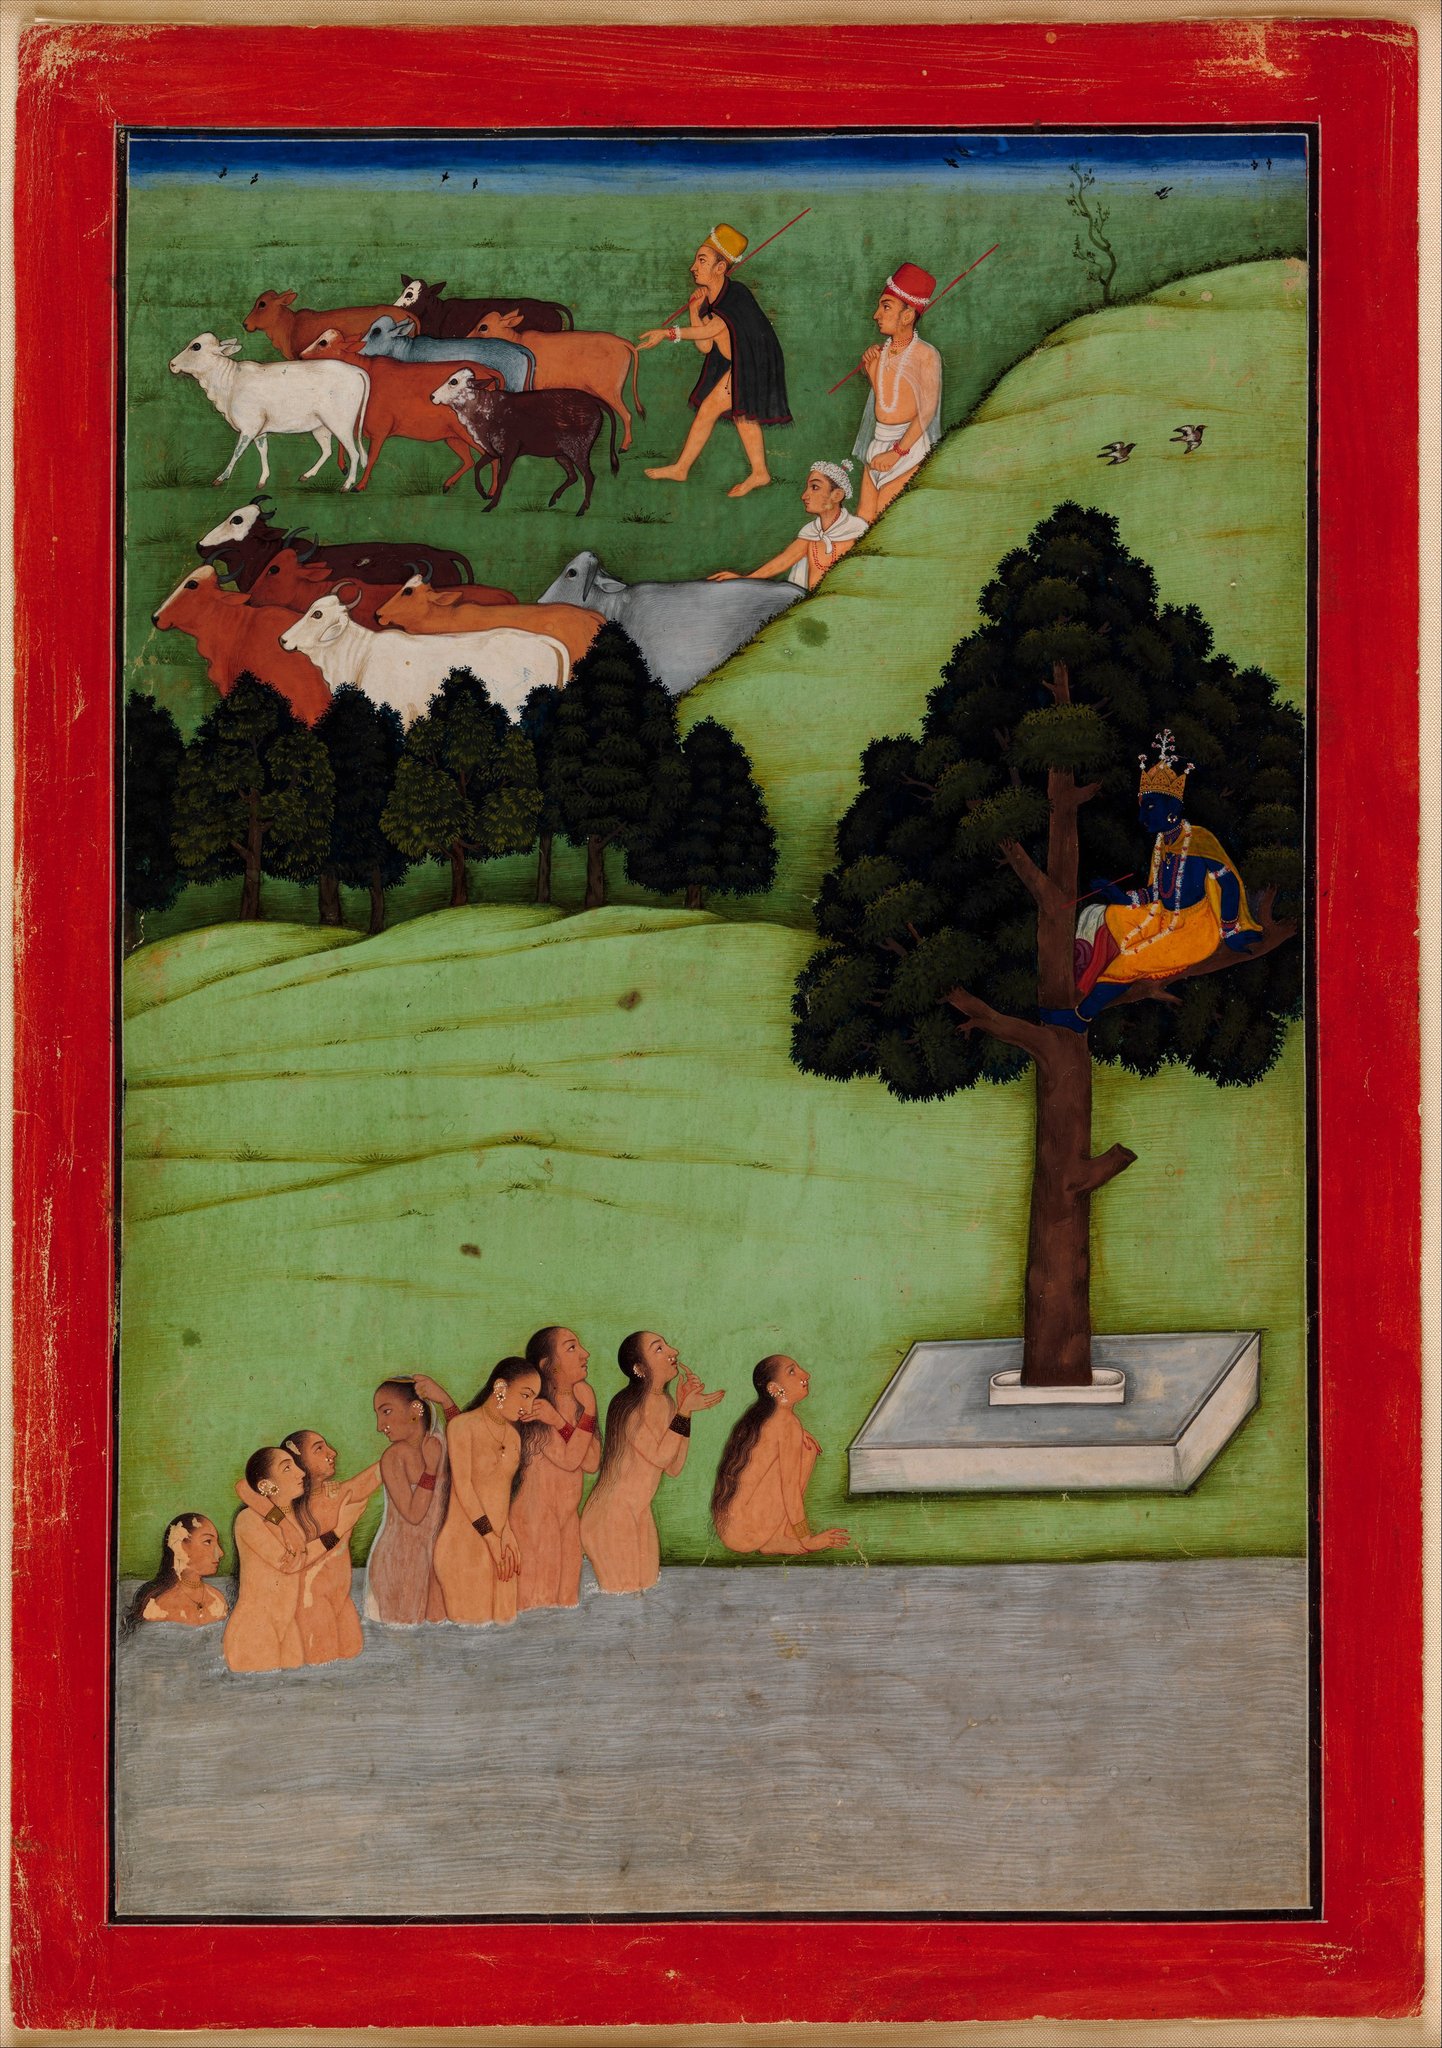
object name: folio from an illustrated manuscript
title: "Krishna Steals the Clothing of the Gopis (Female Cowherds)", Folio from the Devotional Text of the Bhagavata Purana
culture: indian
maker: the early master at the court of mandi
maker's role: artist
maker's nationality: indian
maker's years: 1610-1685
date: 1640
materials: gold, paper, watercolor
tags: women,cows,trees,krishna,bathing